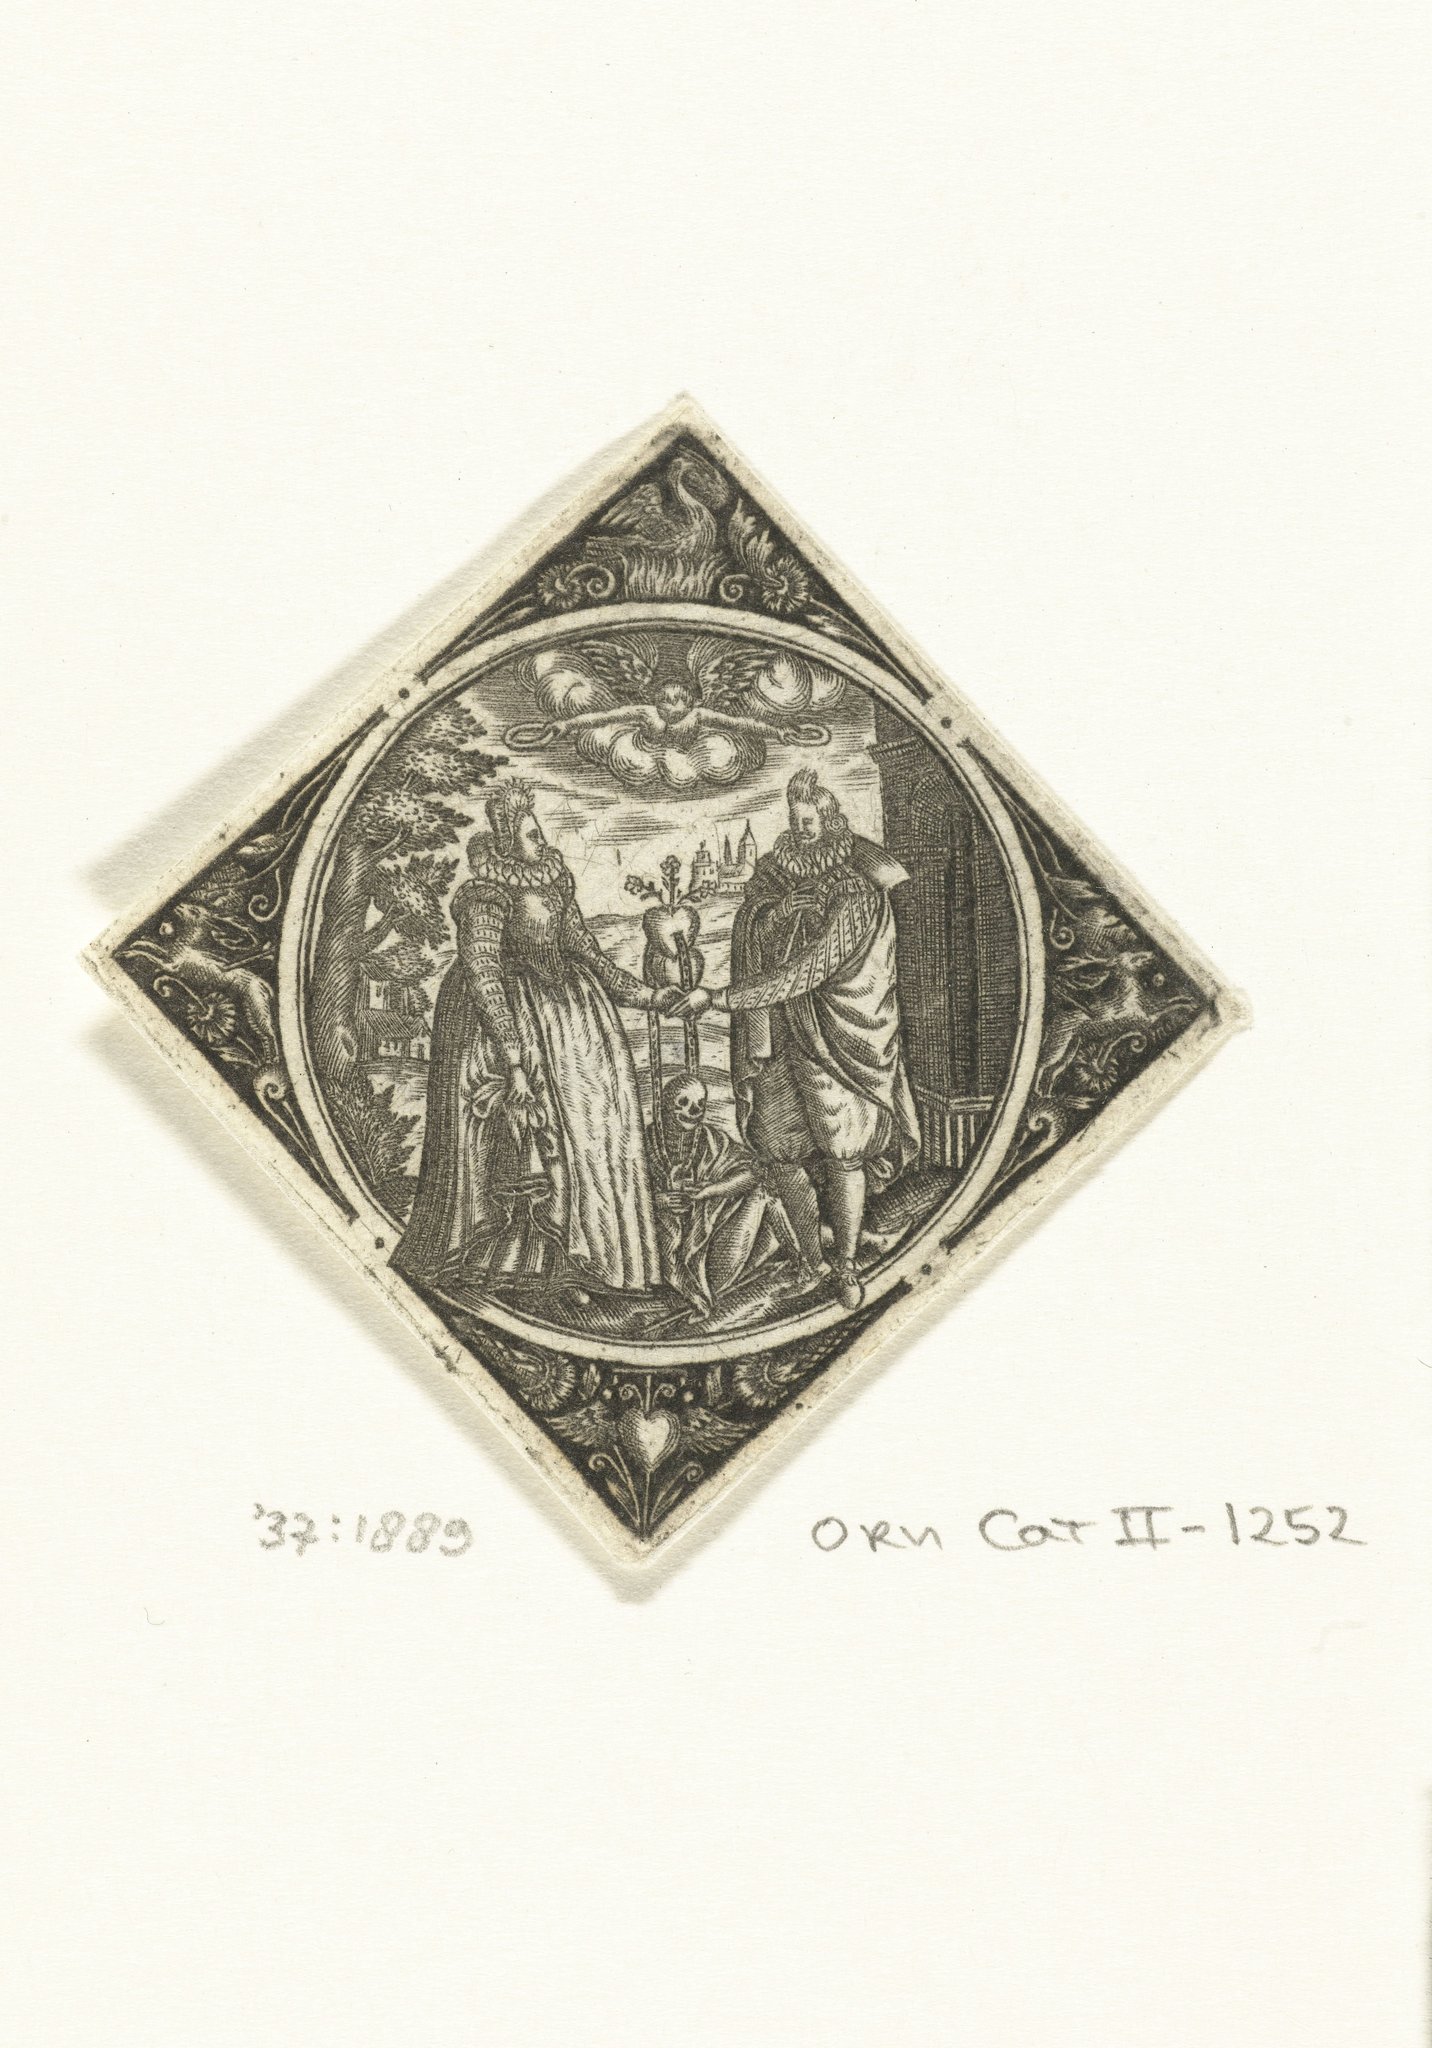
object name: print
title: Huwelijksmedaillon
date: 1618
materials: paper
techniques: engraving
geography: netherlands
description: Op het medaillon zijn een man en een vrouw afgebeeld die elkaar de hand reiken. Tussen hen in zit de dood. Afdruk van een gegraveerd zilveren medaillon.